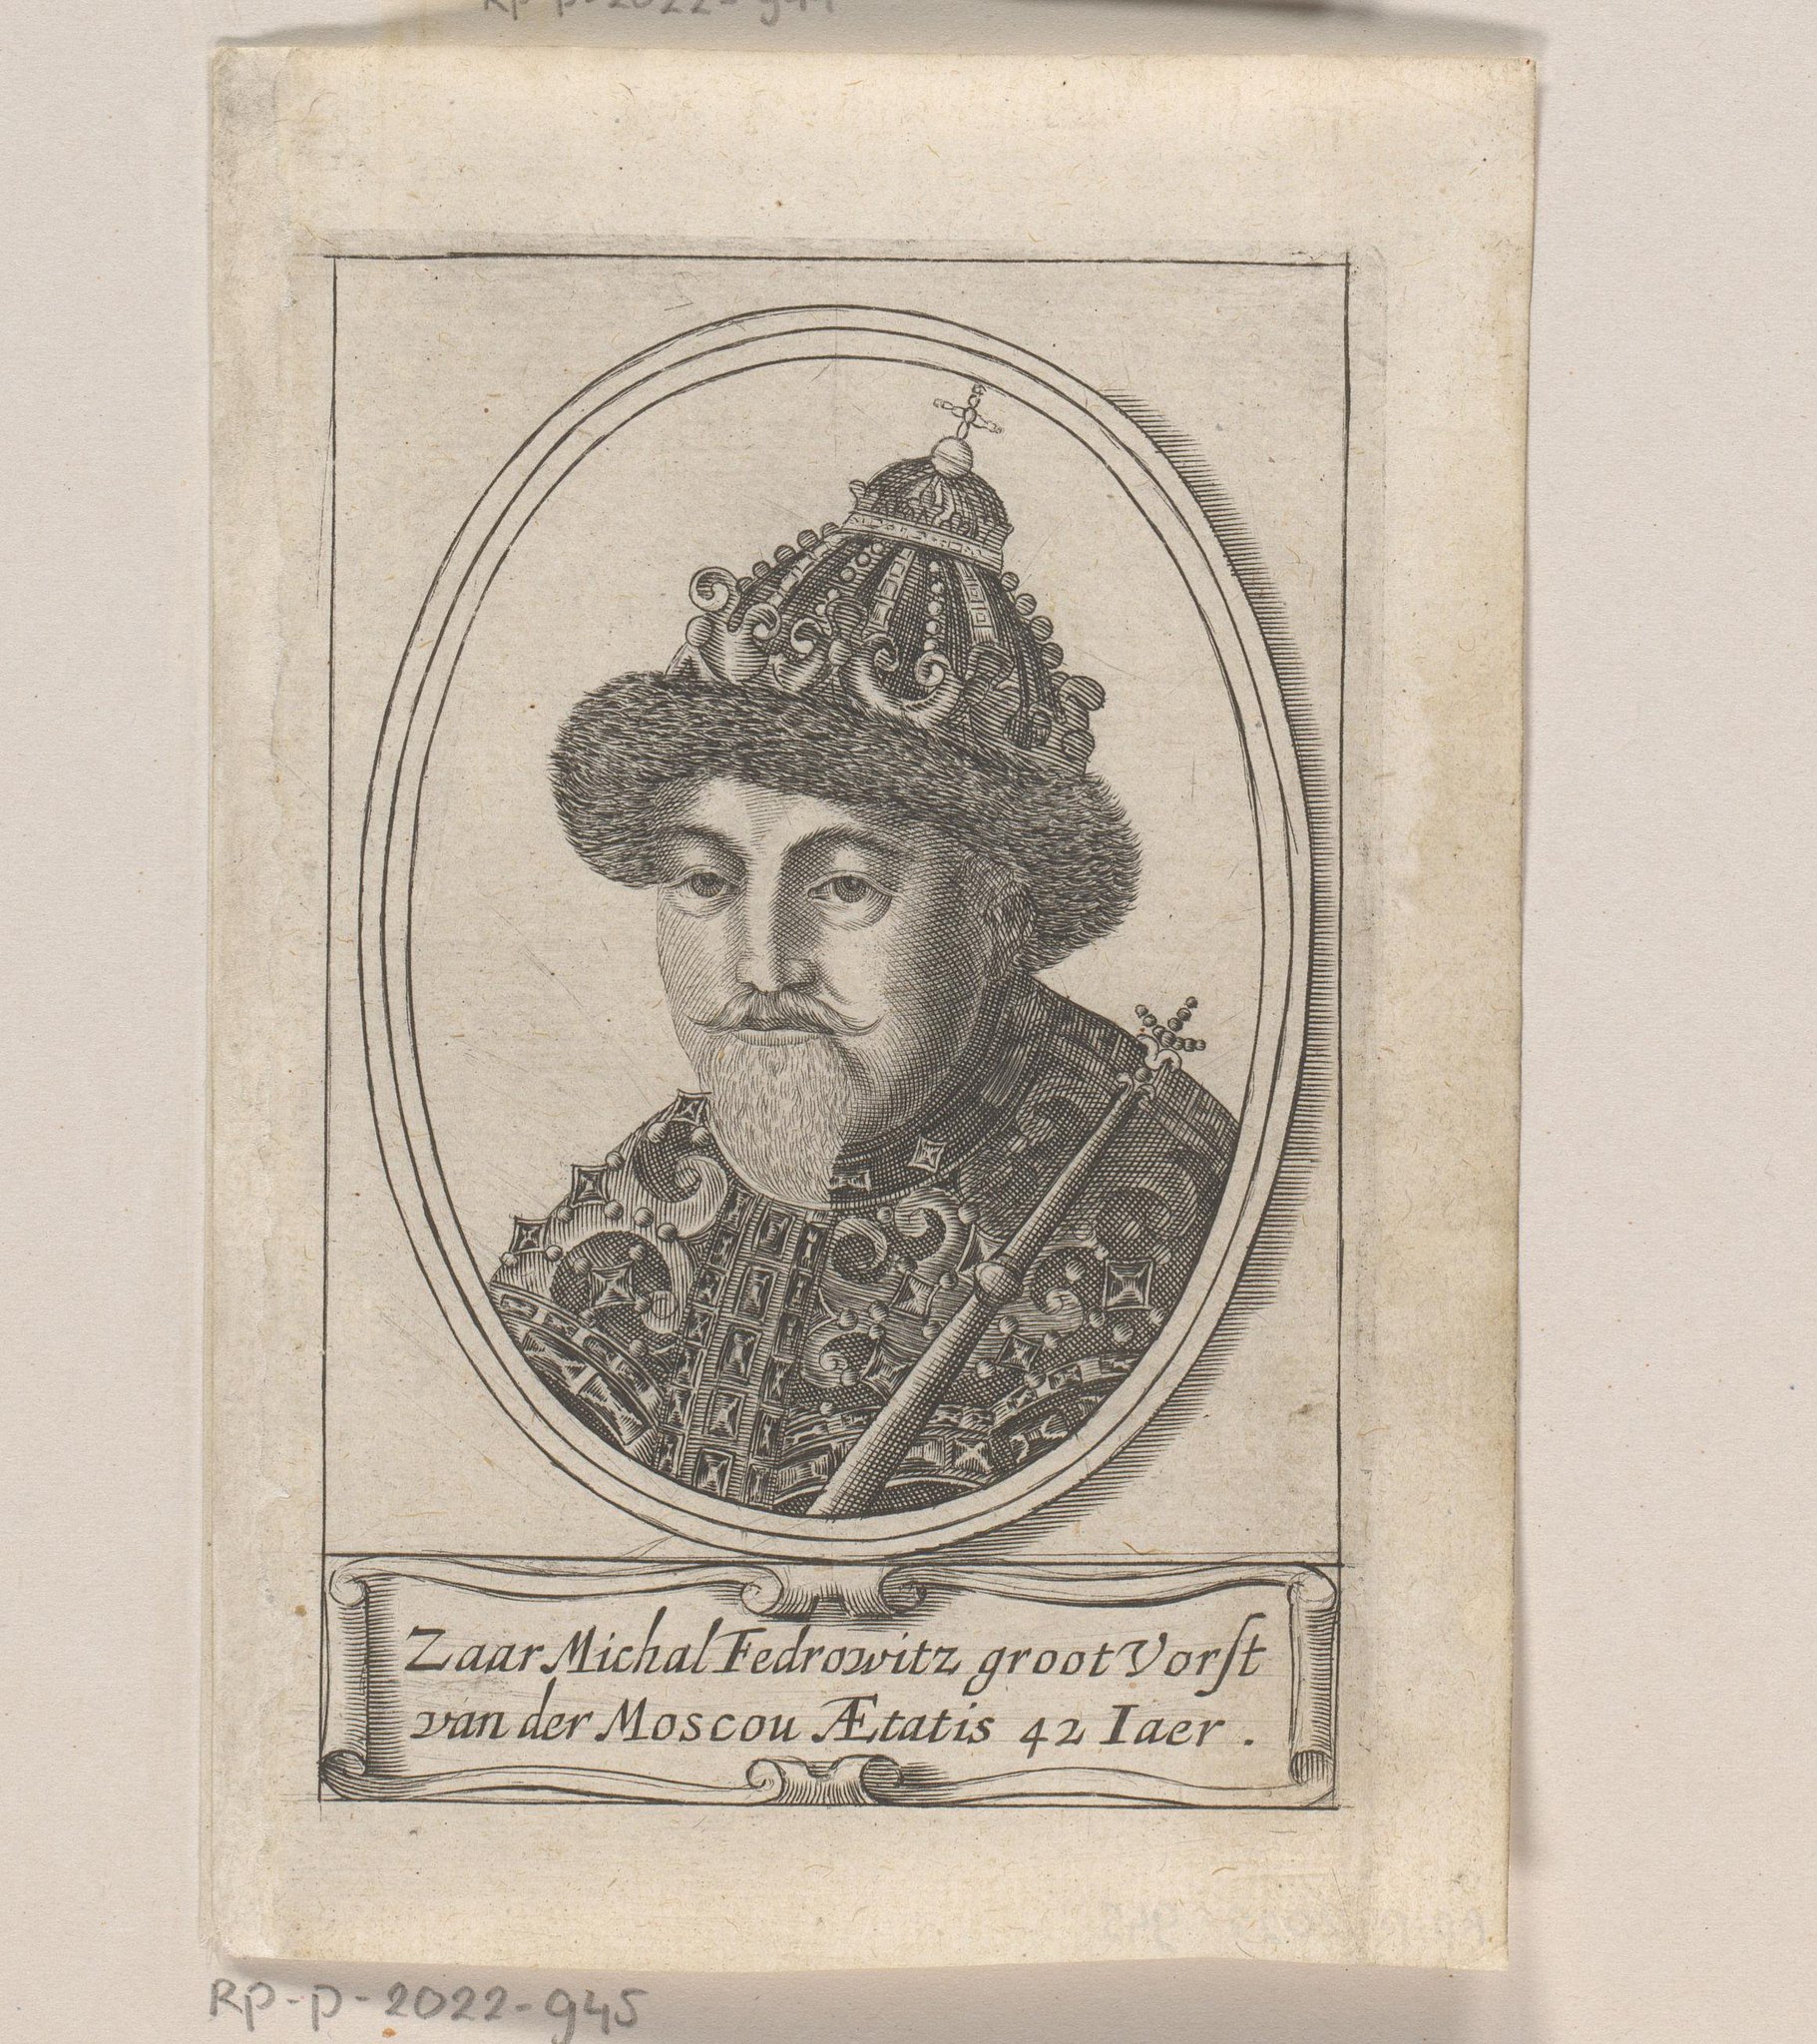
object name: book illustration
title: Portret van tsaar Michaël Fjodorovitsj Romanov op 42-jarige leeftijd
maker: Anonymous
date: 1651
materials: paper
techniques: engraving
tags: historical persons, emperor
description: Prent waarschijnlijk uit: Olearius, Adam, Johann Albrecht von Mandelslo en Dirck van Wageningh. Beschijvingh vande nieuwe Parciaensche ofte Orientaelsche reyse (...). Amsterdam: Jacob Benjamin, 1651.